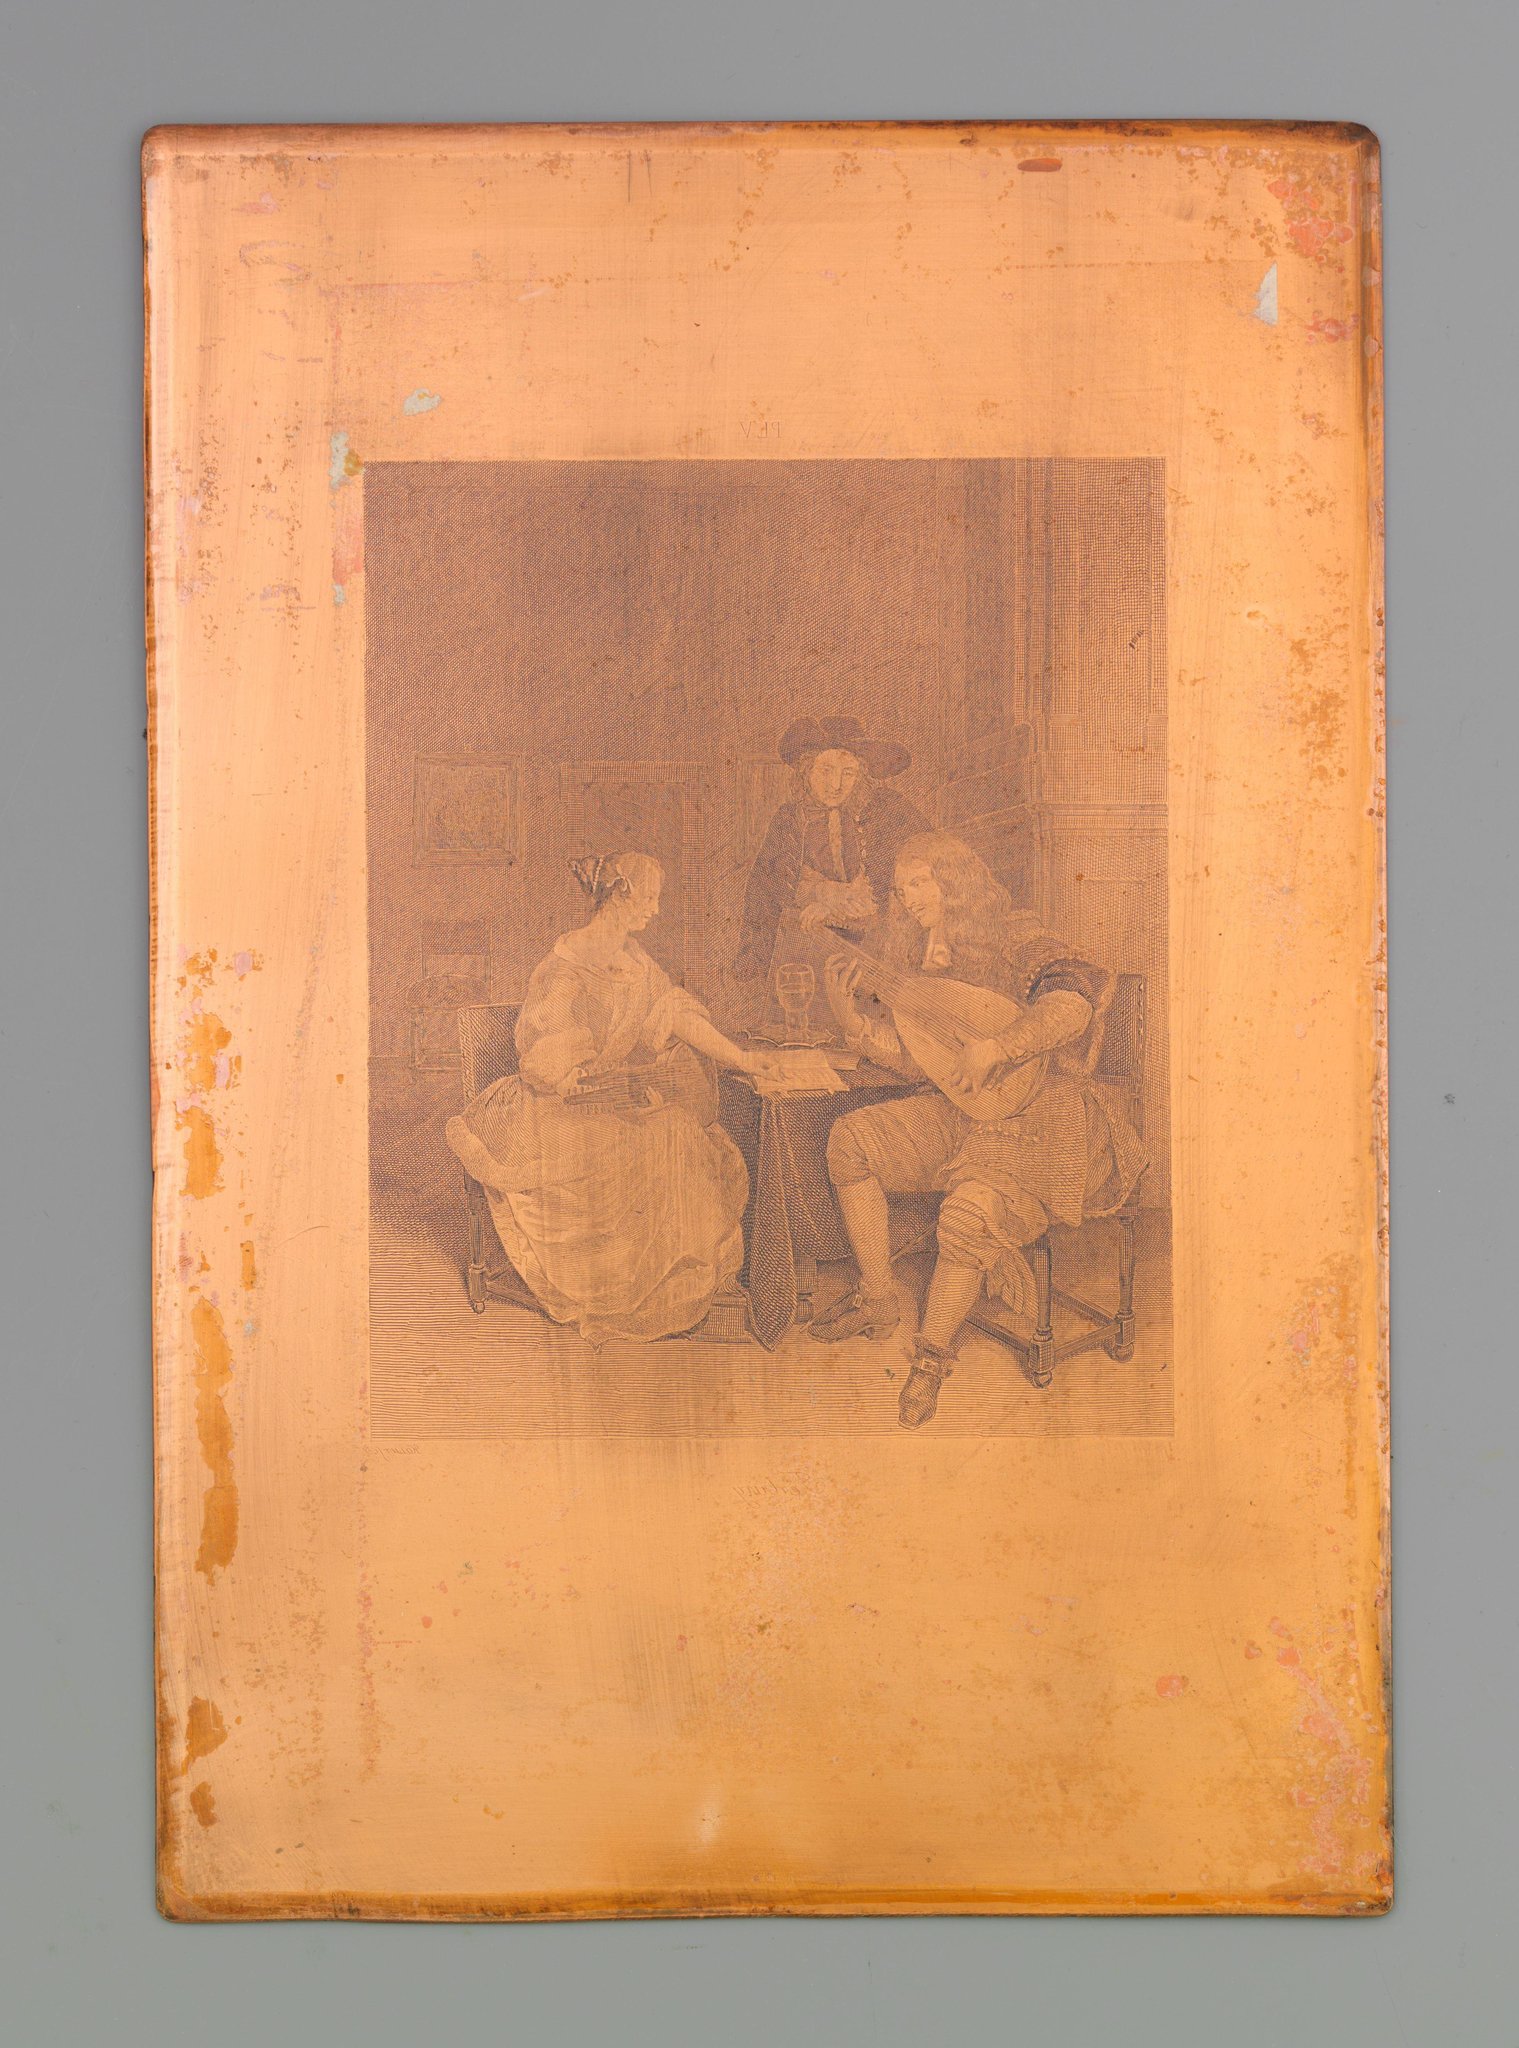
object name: copper plate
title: Musicerend paar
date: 1823-1900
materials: copper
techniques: etching